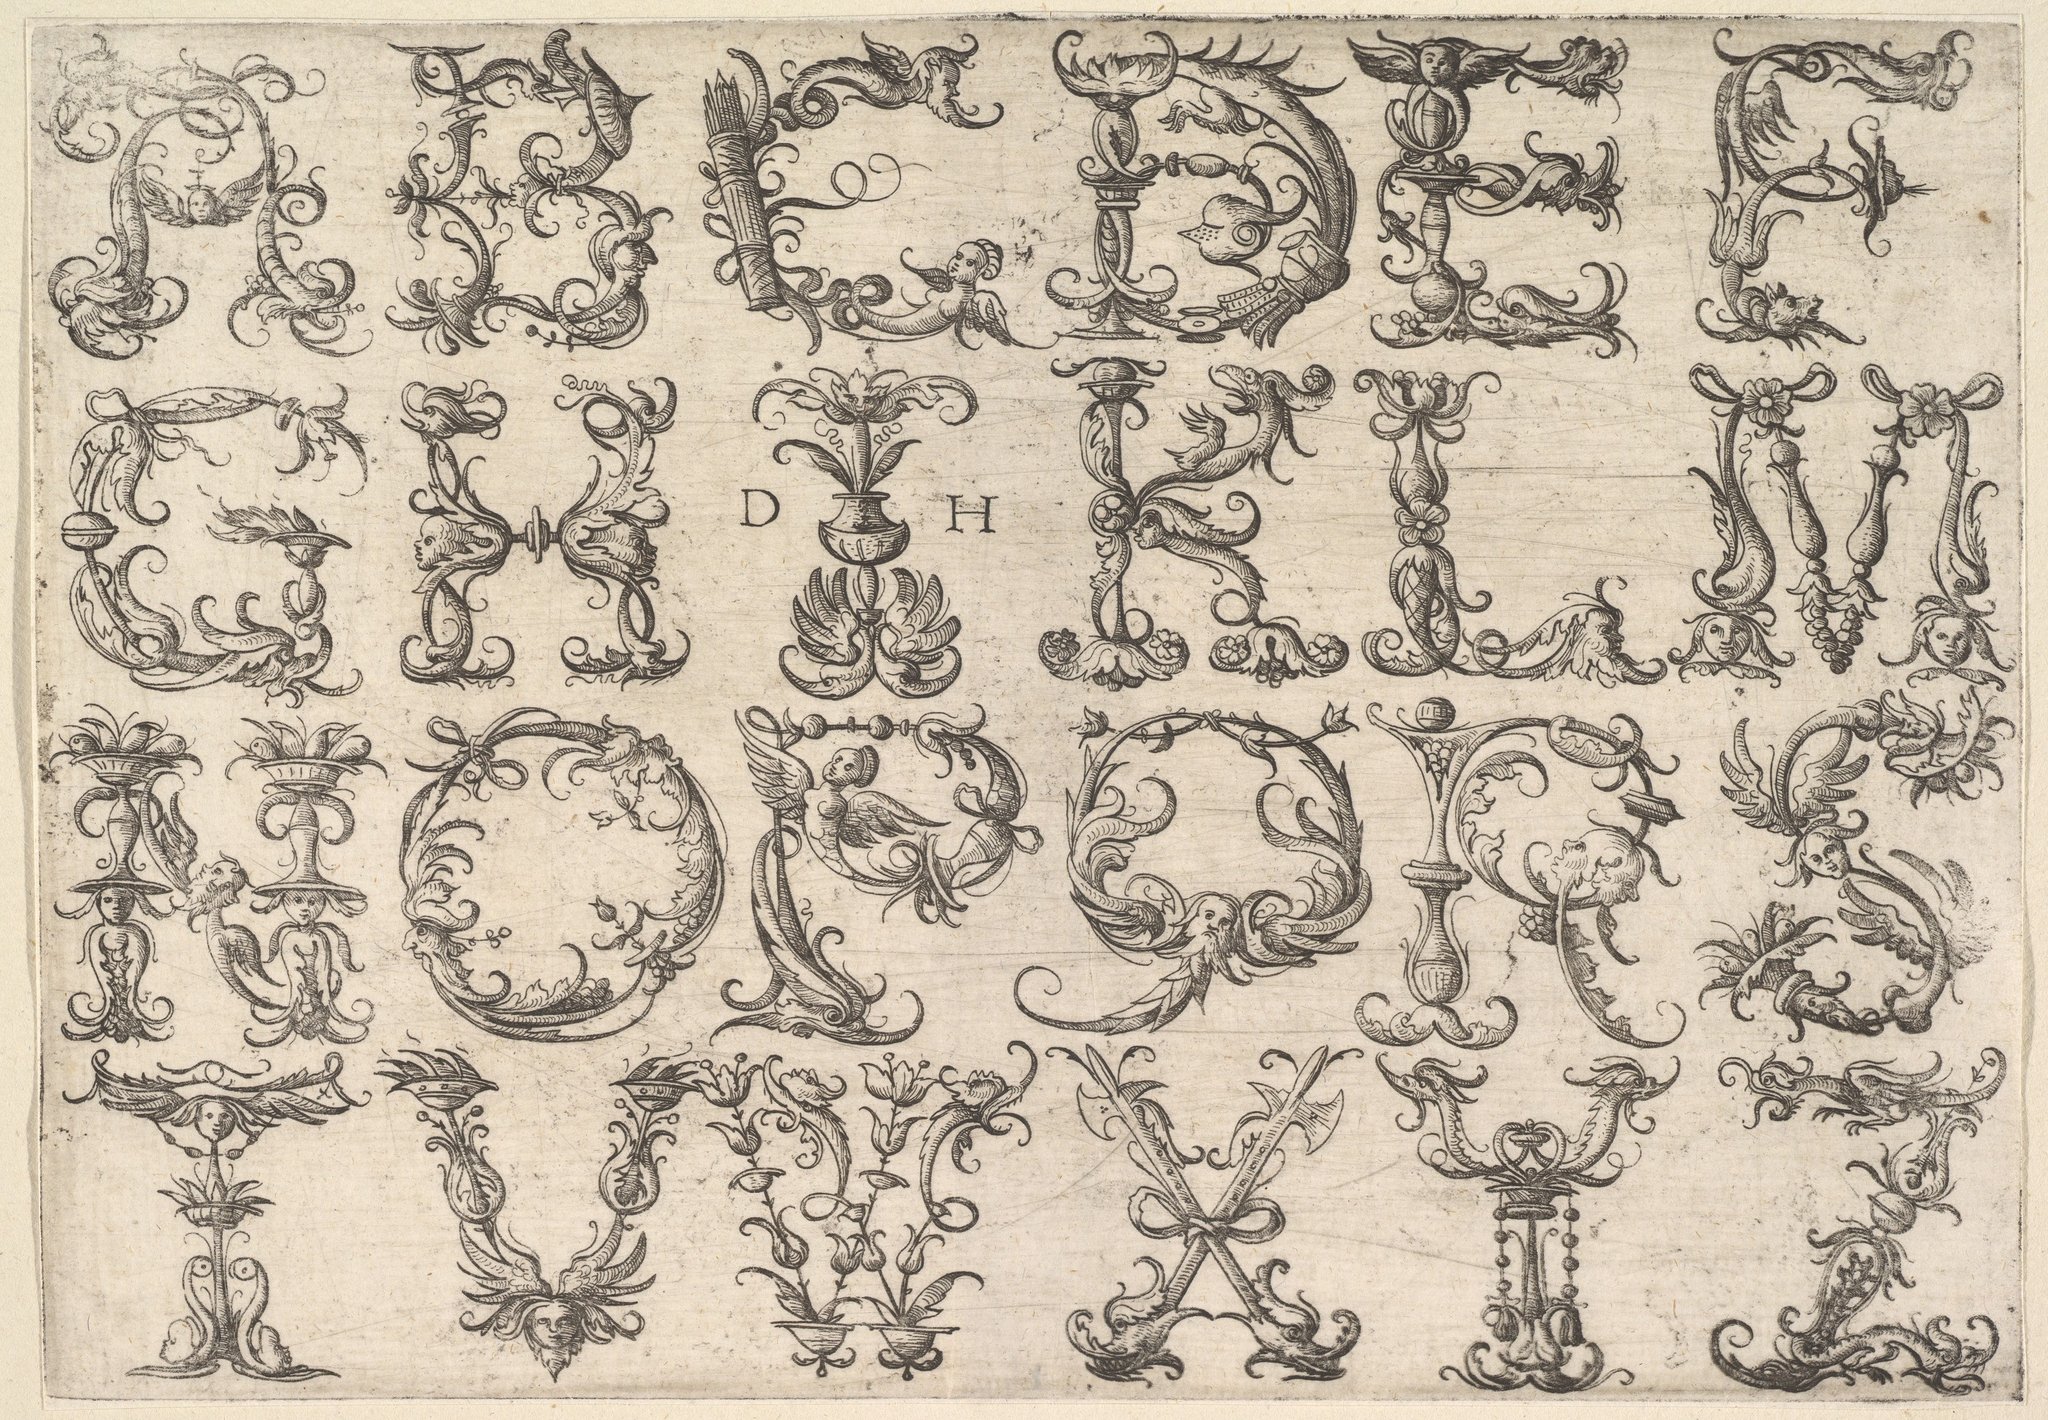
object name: print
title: Ornamented Roman Majuscule Alphabet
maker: daniel hopfer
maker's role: artist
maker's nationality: german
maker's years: 1470-1536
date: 1520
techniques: etching